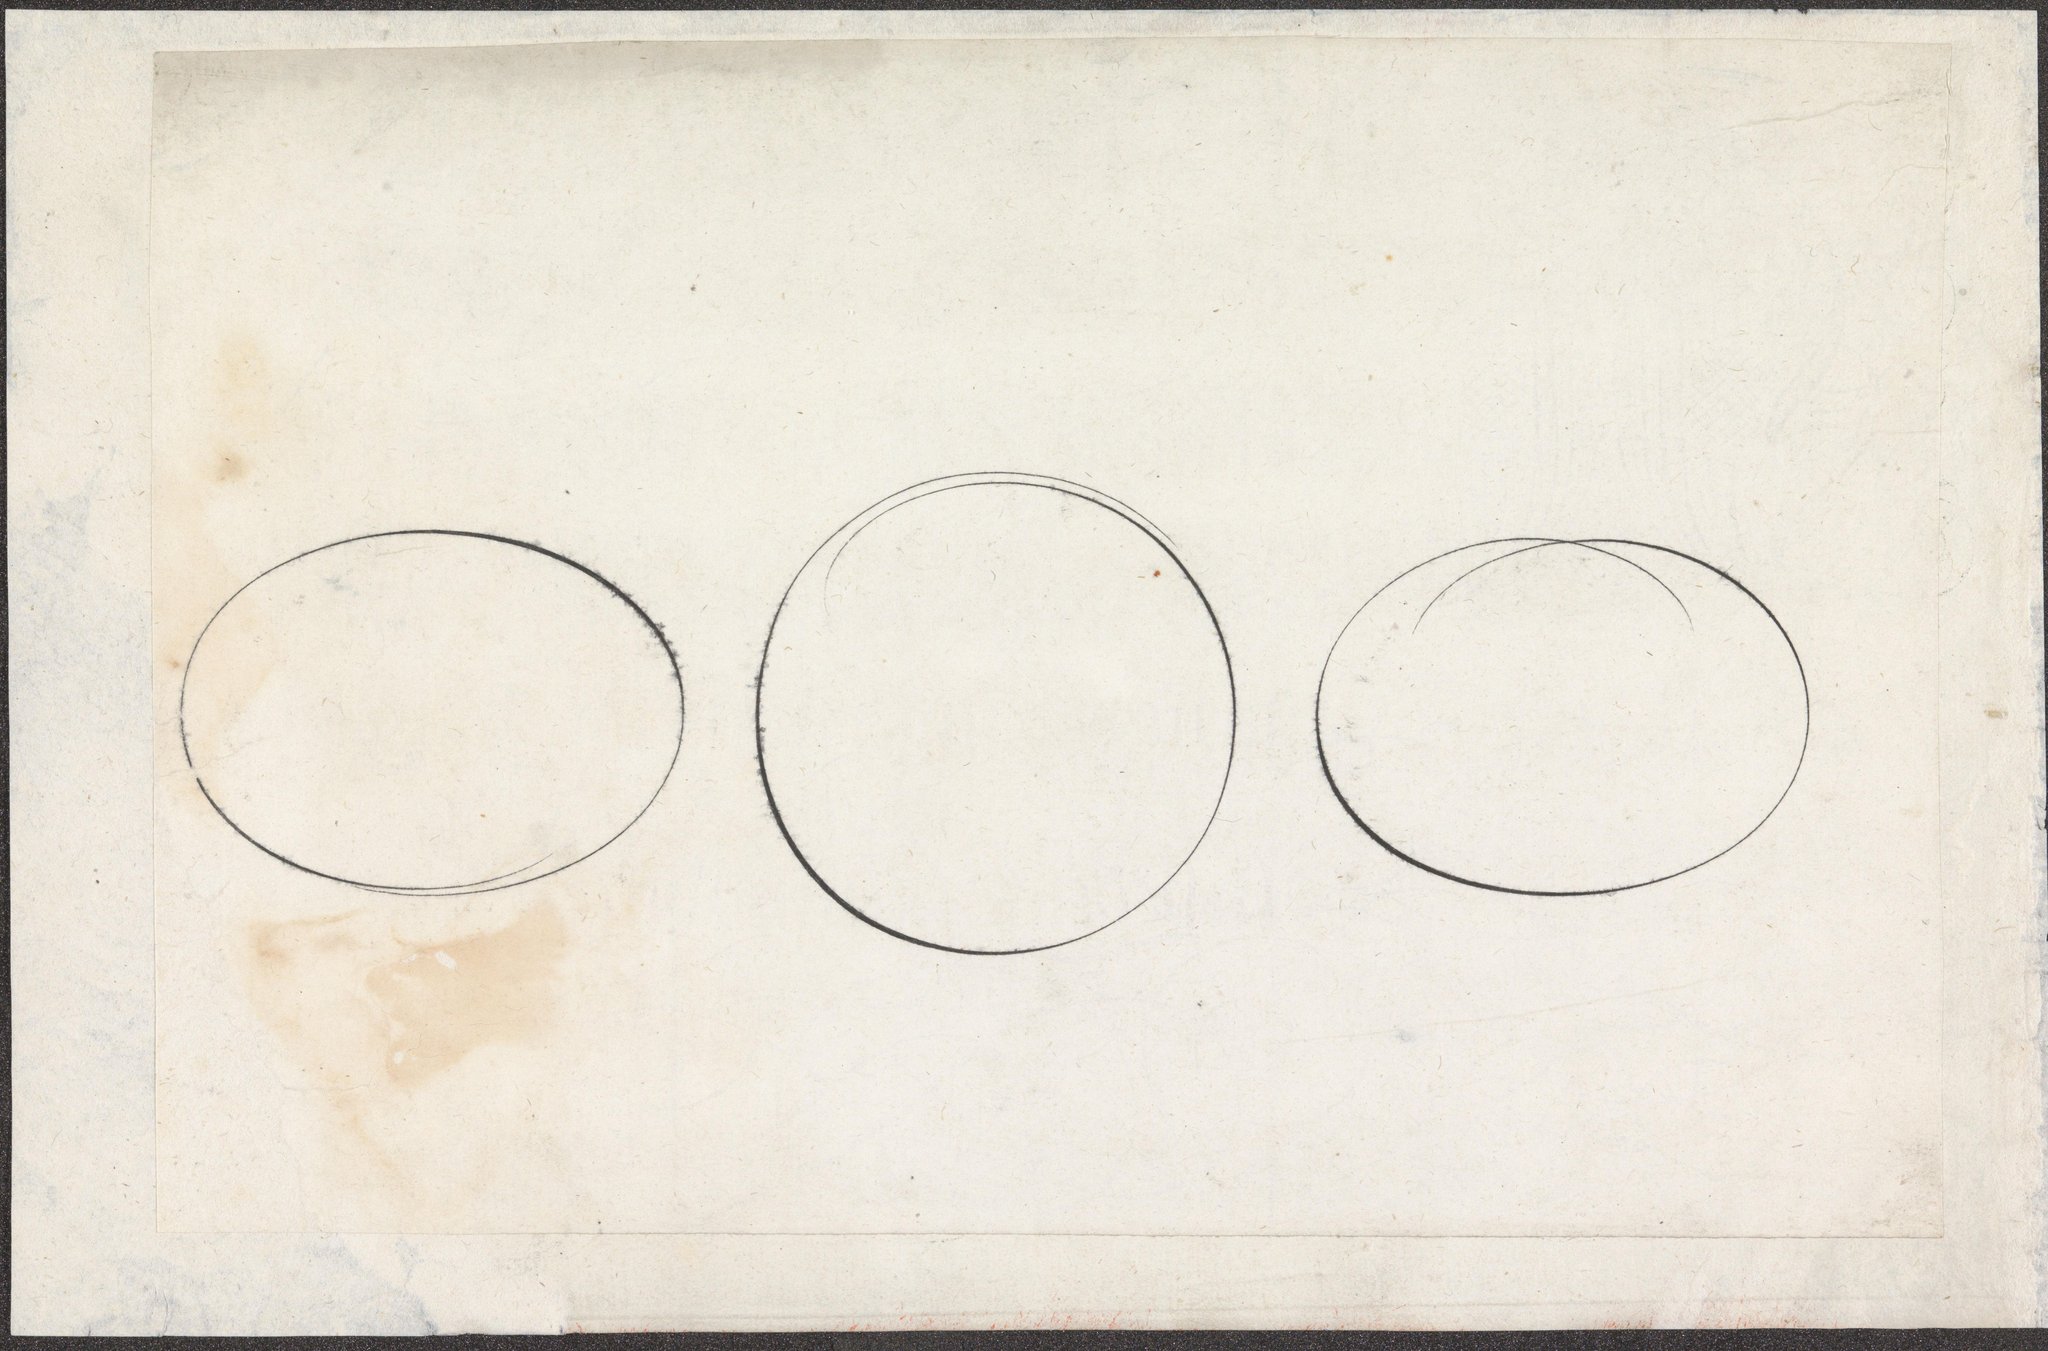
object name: album leaf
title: Drie ronde vormen, niet gesloten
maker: jan van de velde (i)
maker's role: painter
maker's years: 1568-1623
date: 1605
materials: ink, paper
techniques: calligraphy, pen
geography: rotterdam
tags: calligraphy, circle (~ planimetry, geometry)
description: Een liggende open ovaal, gevolgd door een open cirkel en een liggende open ovaal. Deze tekening maakt deel uit van een album.